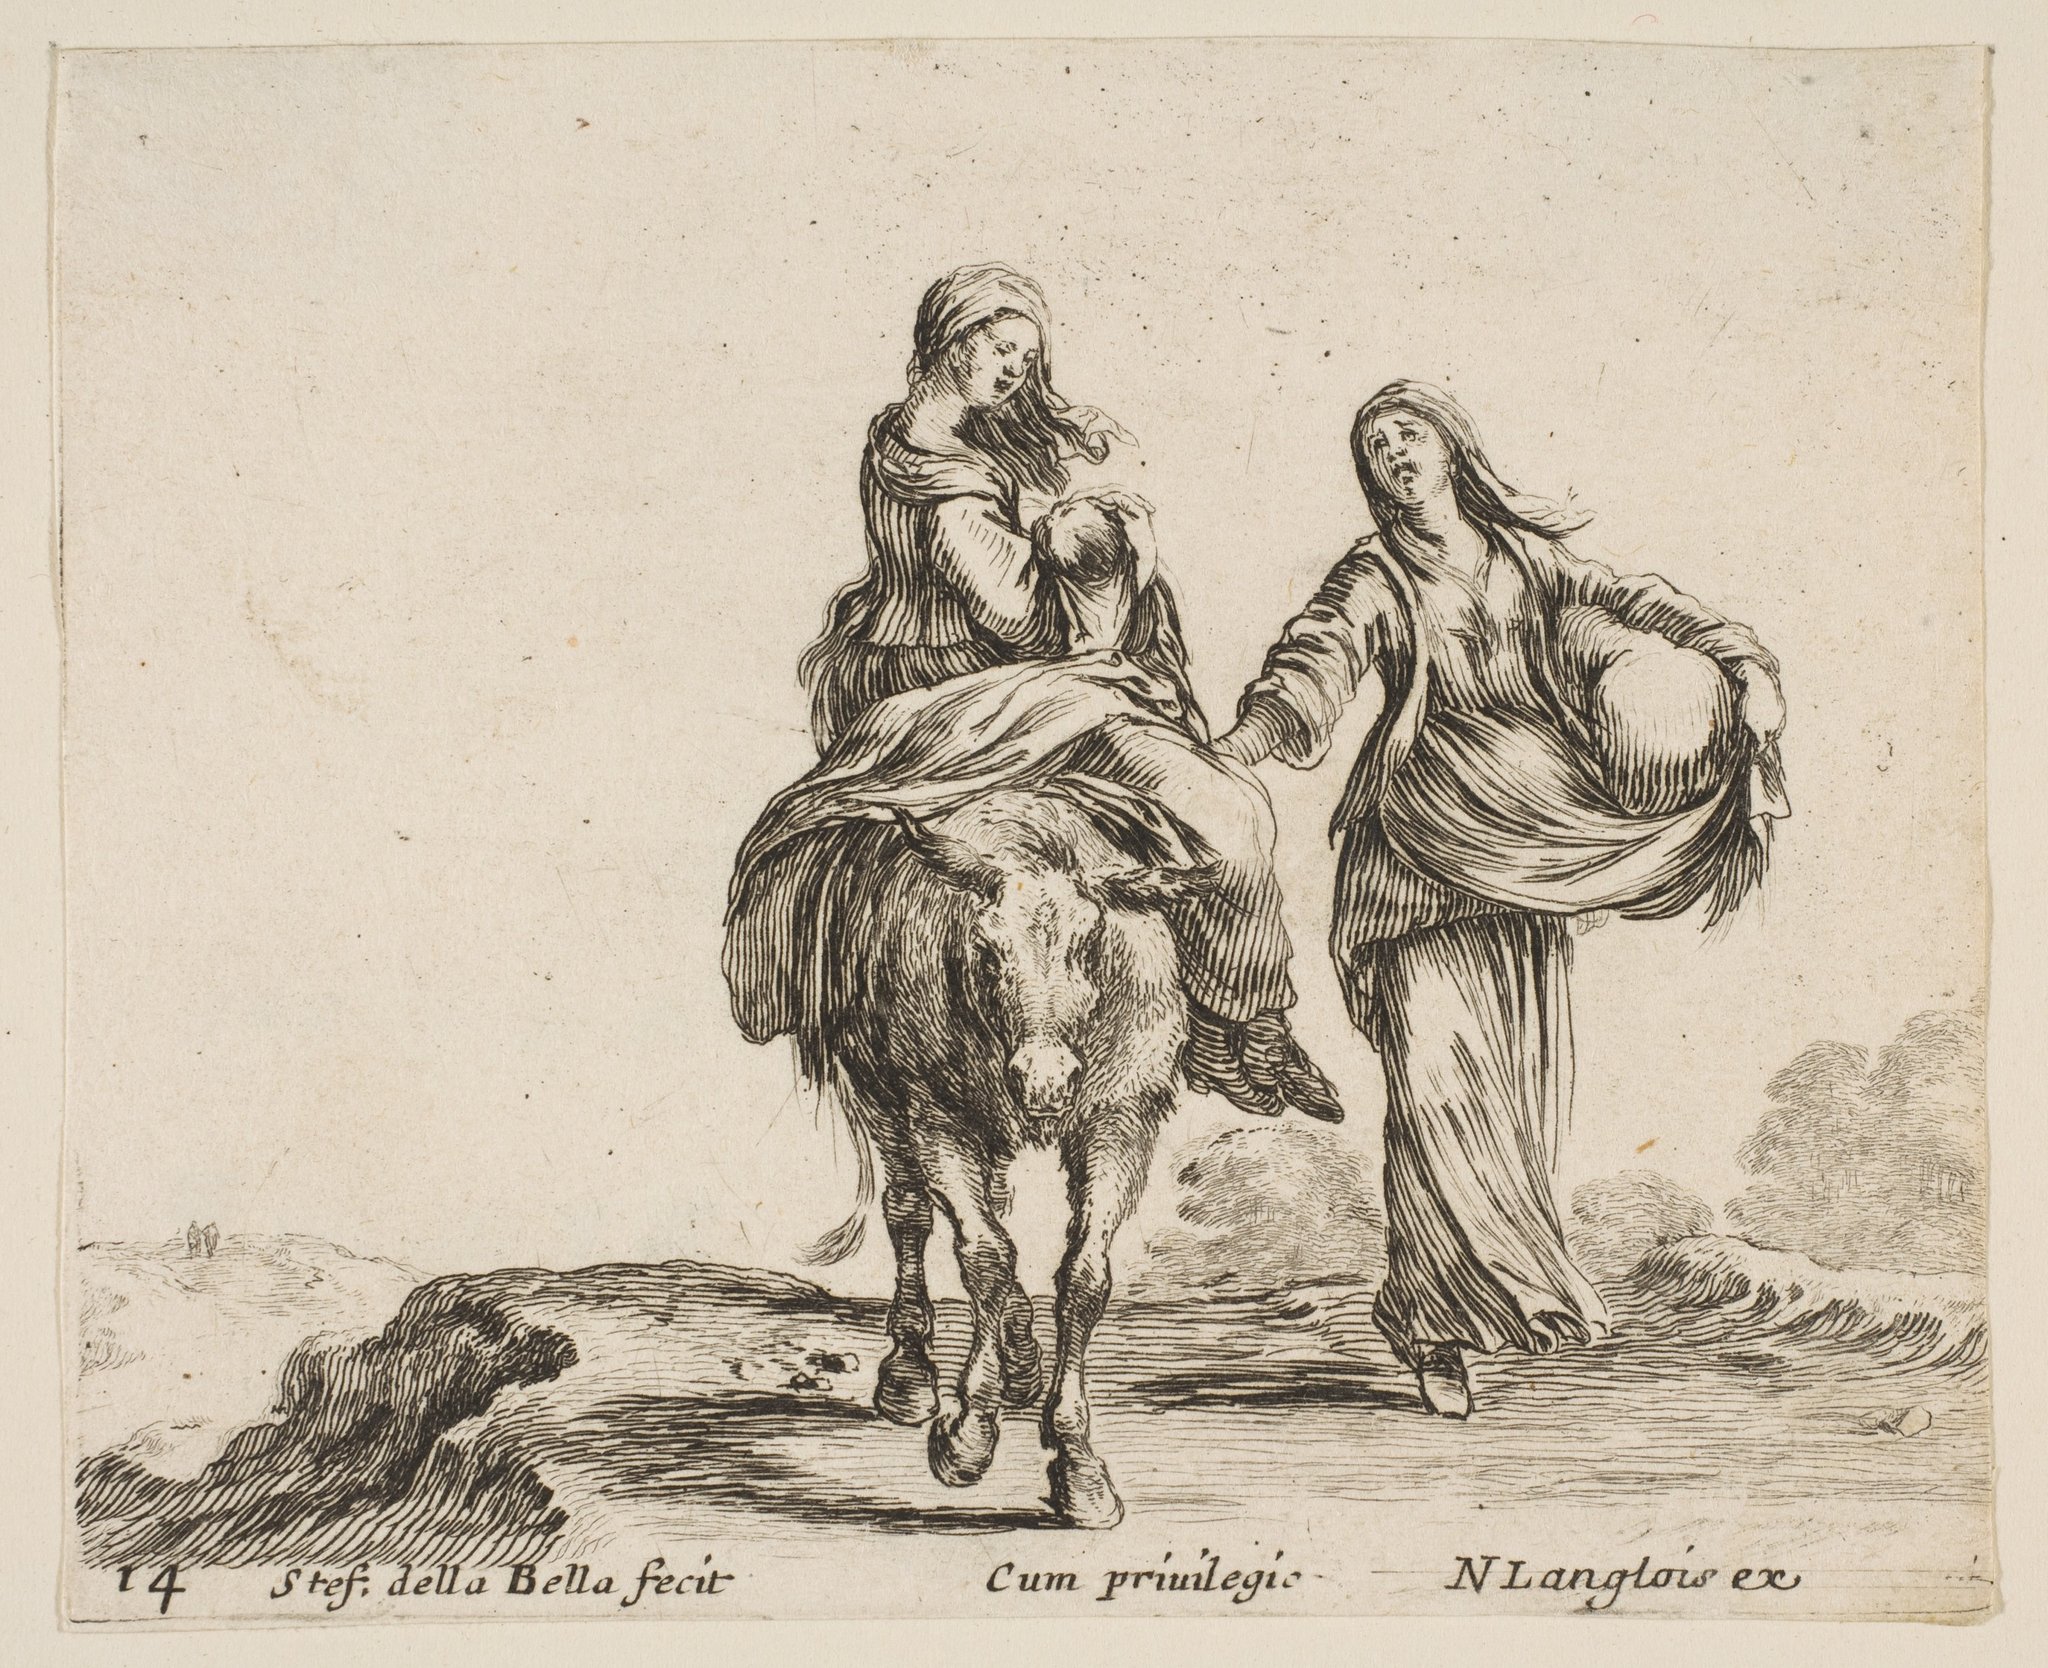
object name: print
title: A young peasant woman and her child sitting side saddle atop a horse in center, another peasant woman to right, holding a large bag in her left arm, plate 14 from "Diversi capricci"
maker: stefano della bella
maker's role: artist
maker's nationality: italian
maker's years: 1610-1664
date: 1644-1647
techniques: etching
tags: children,women,horses